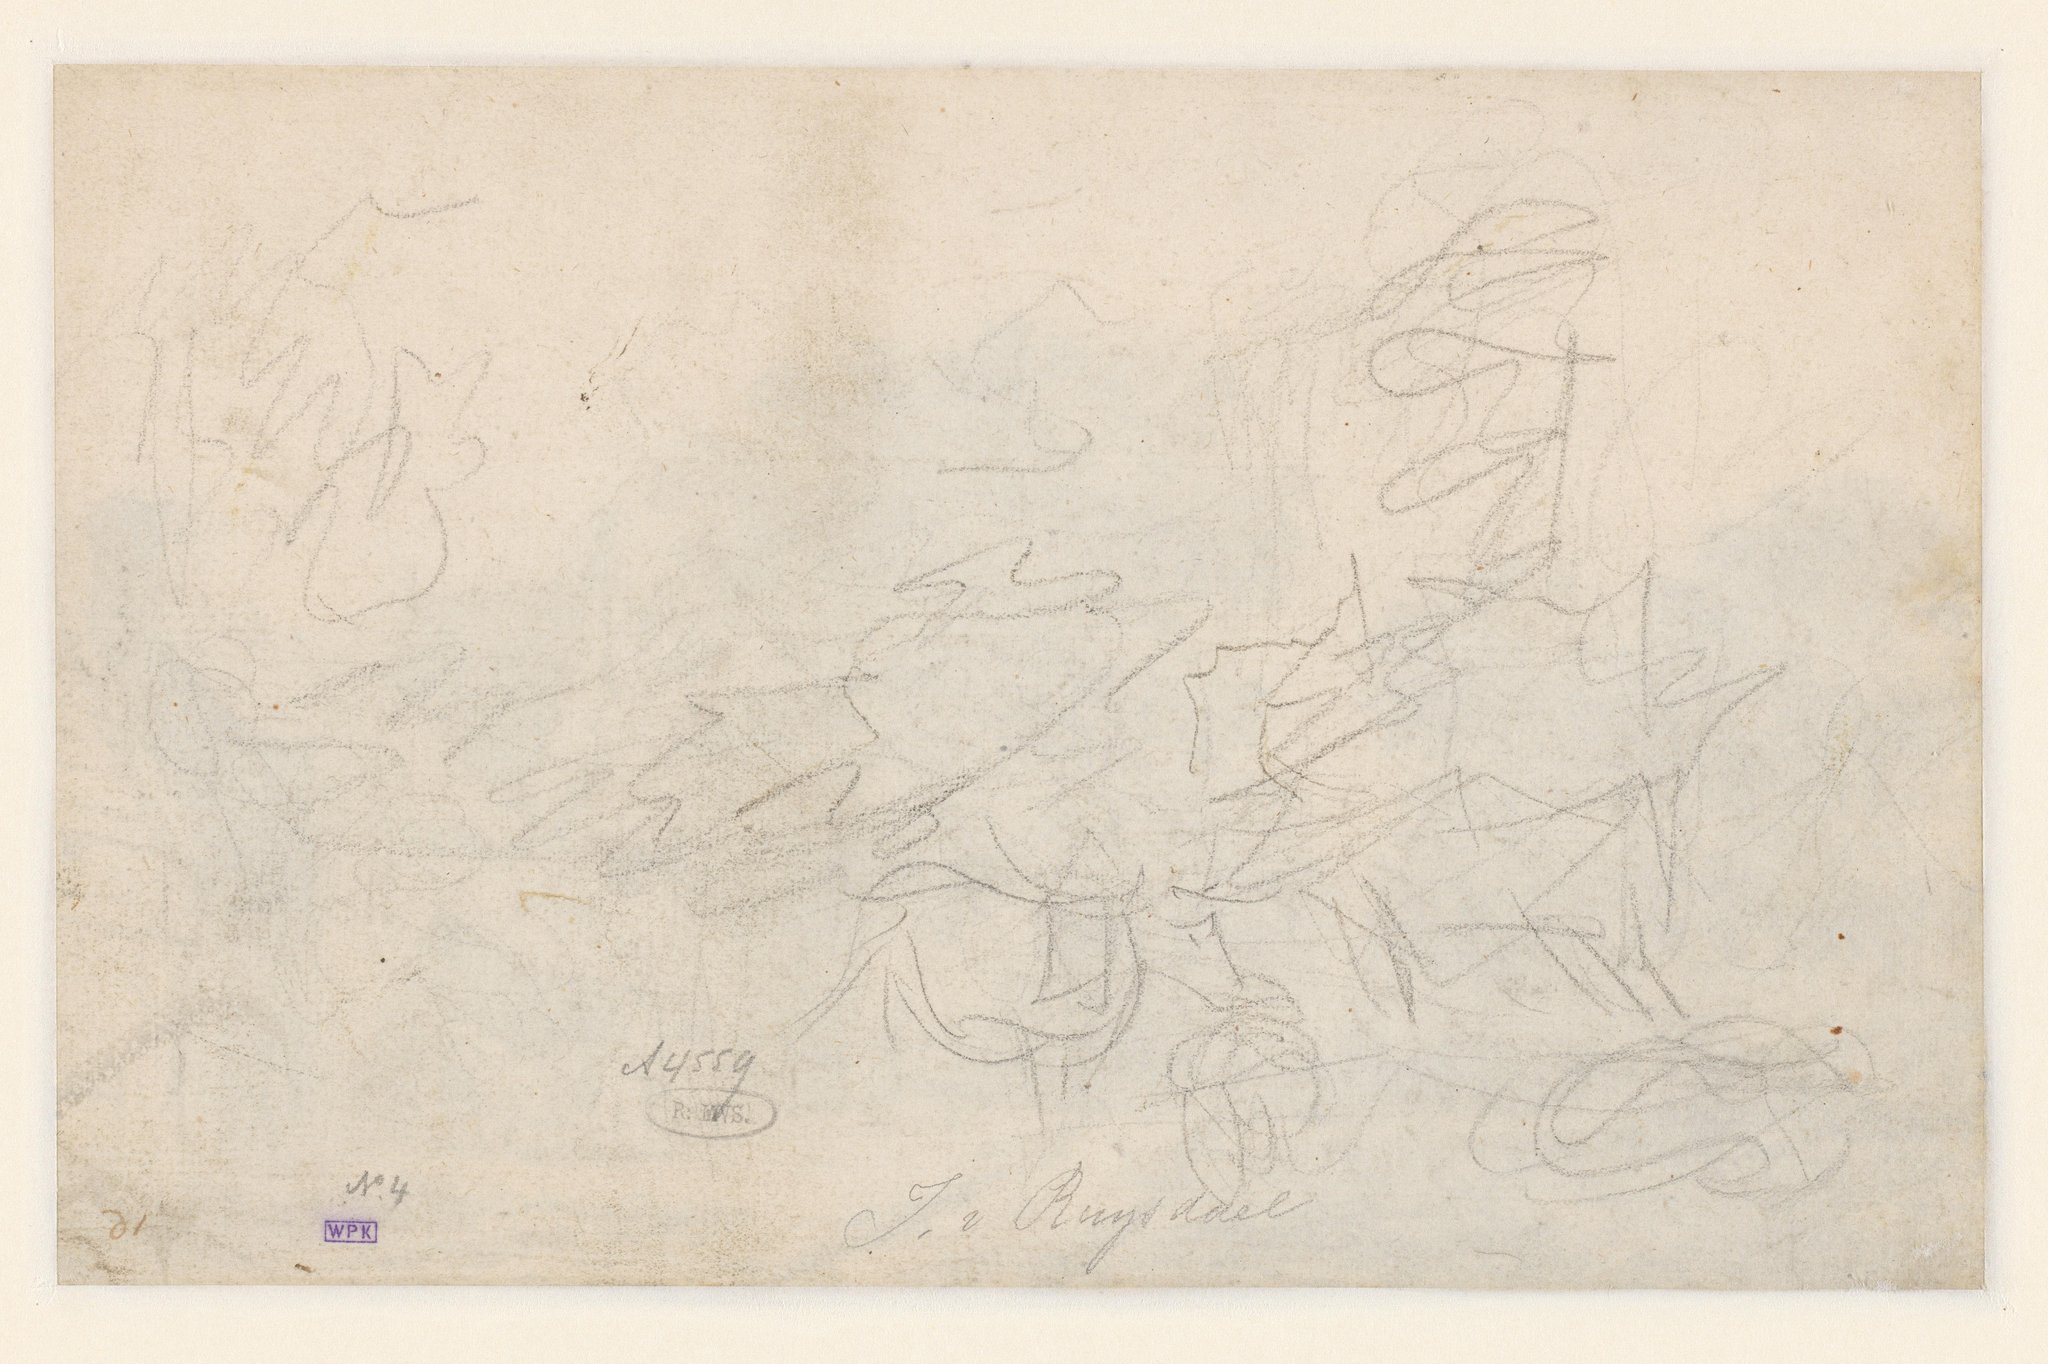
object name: drawing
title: Figure with a Cow or Horse in a Landscape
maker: jacob isaacksz van ruisdael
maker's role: draughtsman, painter, print maker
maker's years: 1628-1682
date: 1660-1665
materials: chalk, paper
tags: prospect of village, silhouette of village, village street